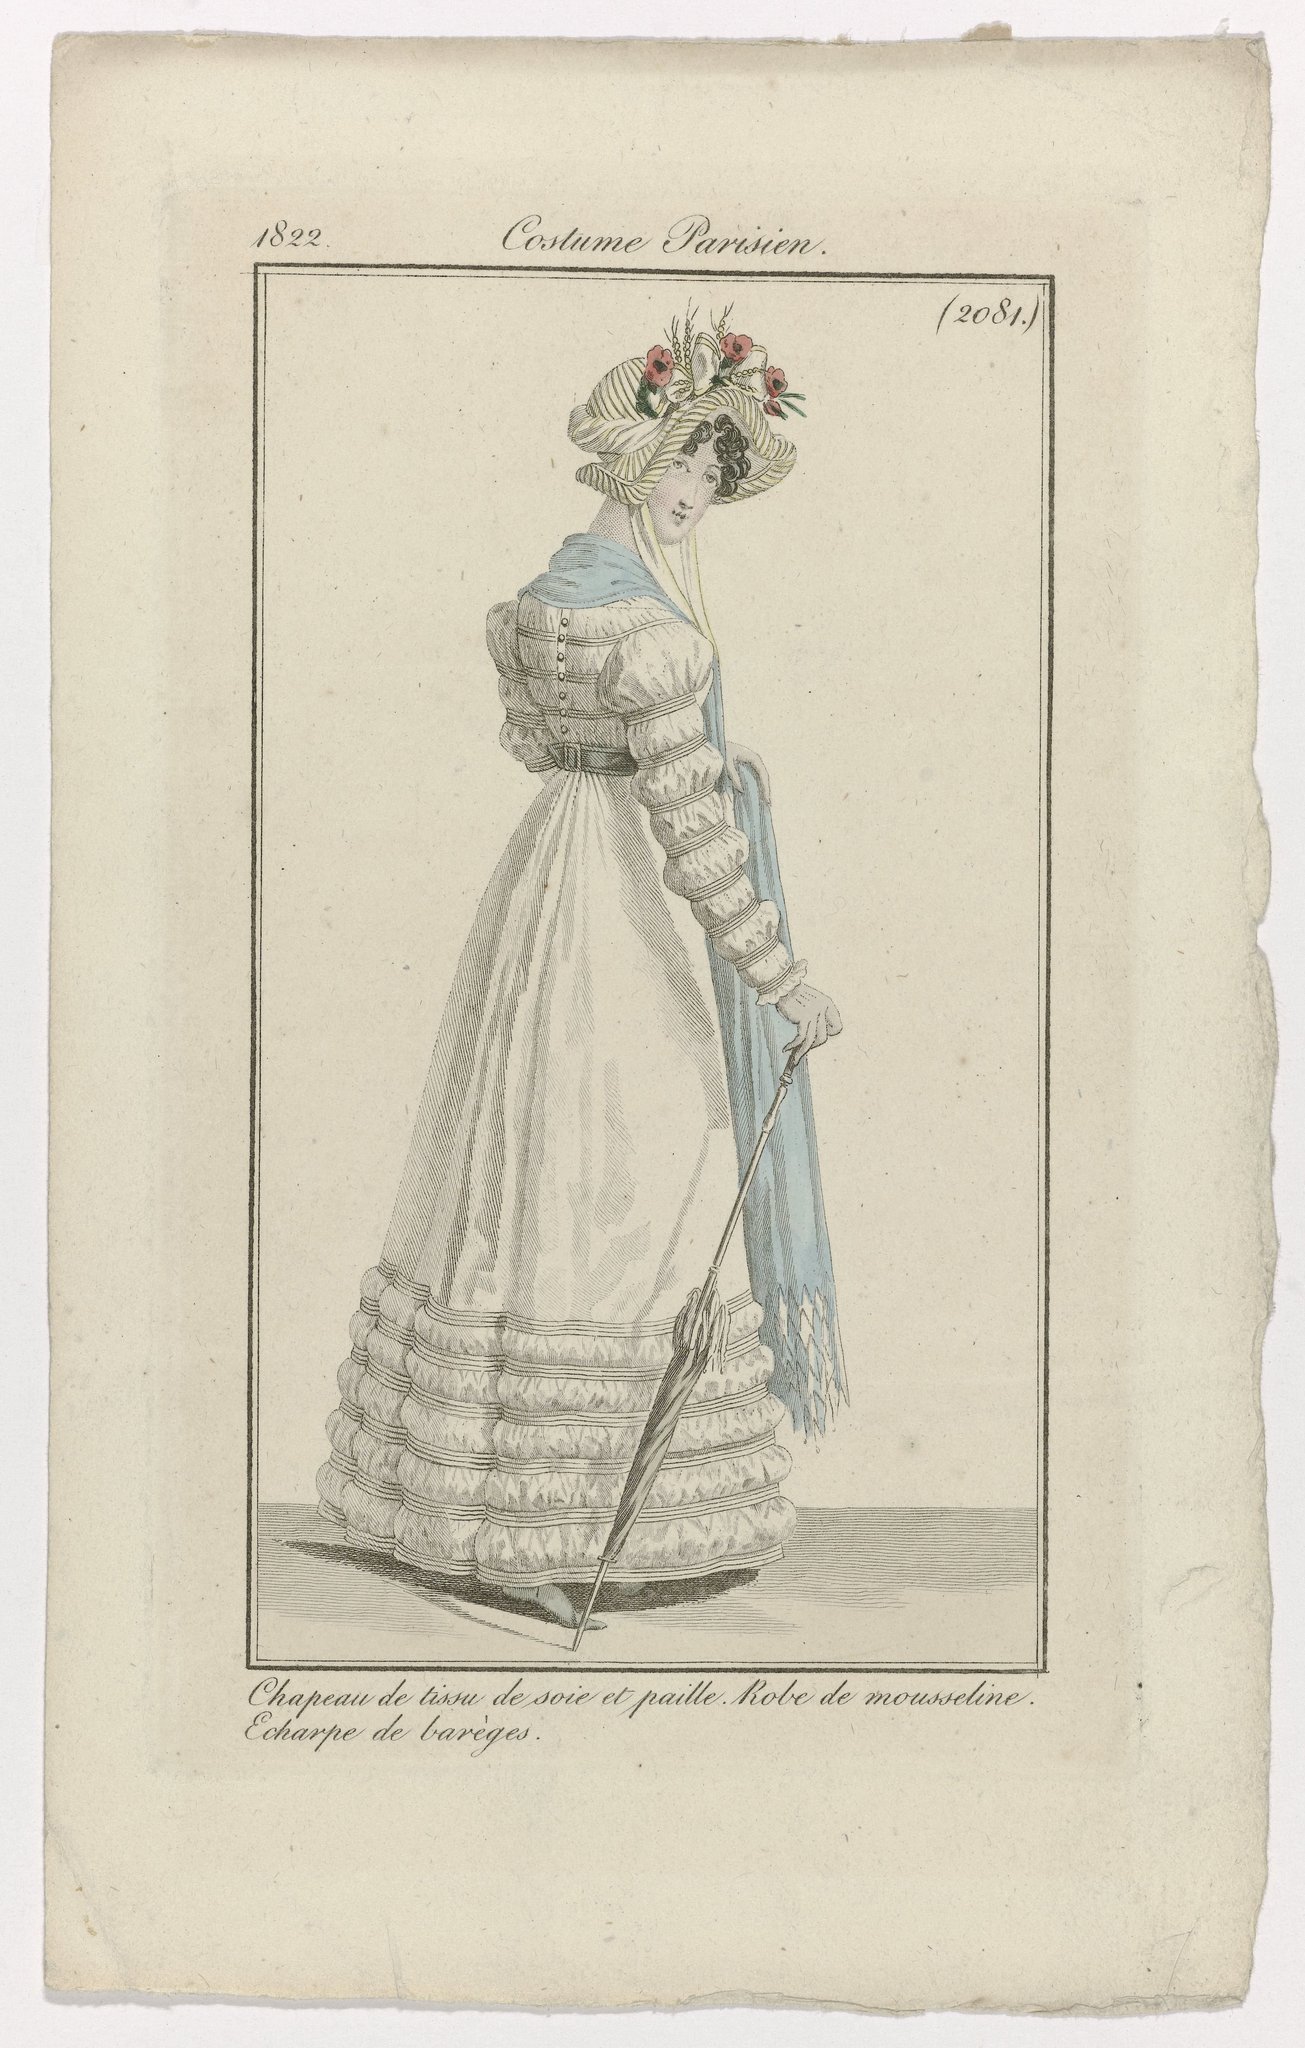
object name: fashion print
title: Journal des Dames et des Modes, Costume Parisien, 15 juillet 1822, (2081): Chapeau de tissu de soi (...)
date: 1822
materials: paper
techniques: engraving, hand coloring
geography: paris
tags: clothing for the upper part of the body (shawl) (+ women's clothes), fashion plates, head-gear: hat (+ women's clothes), shoes, sandals (+ women's clothes), gloves, mittens, etc. (+ women's clothes), dress, gown (+ women's clothes), parasol, sunshade (+ women's clothes), belt, girdle, waistband (+ women's clothes)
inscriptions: caption: ‘Chapeau de tissu de soie et paille. Robe de mousseline. Echarpe de barèges.’, title: ‘Costume Parisien.’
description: Vrouw, op de rug gezien, met op het hoofd een Hoed van zijde en stro. Zij draagt een japon van mousseline met mamelukkenmouwen. Om de hals een sjaal van 'barèges'. Verdere accessoires: ceintuur, handschoen, parasol, schoen. De prent maakt deel uit van het modetijdschrift Journal des Dames et des Modes, uitgegeven door Pierre de la Mésangère, Parijs, 1797-1839.